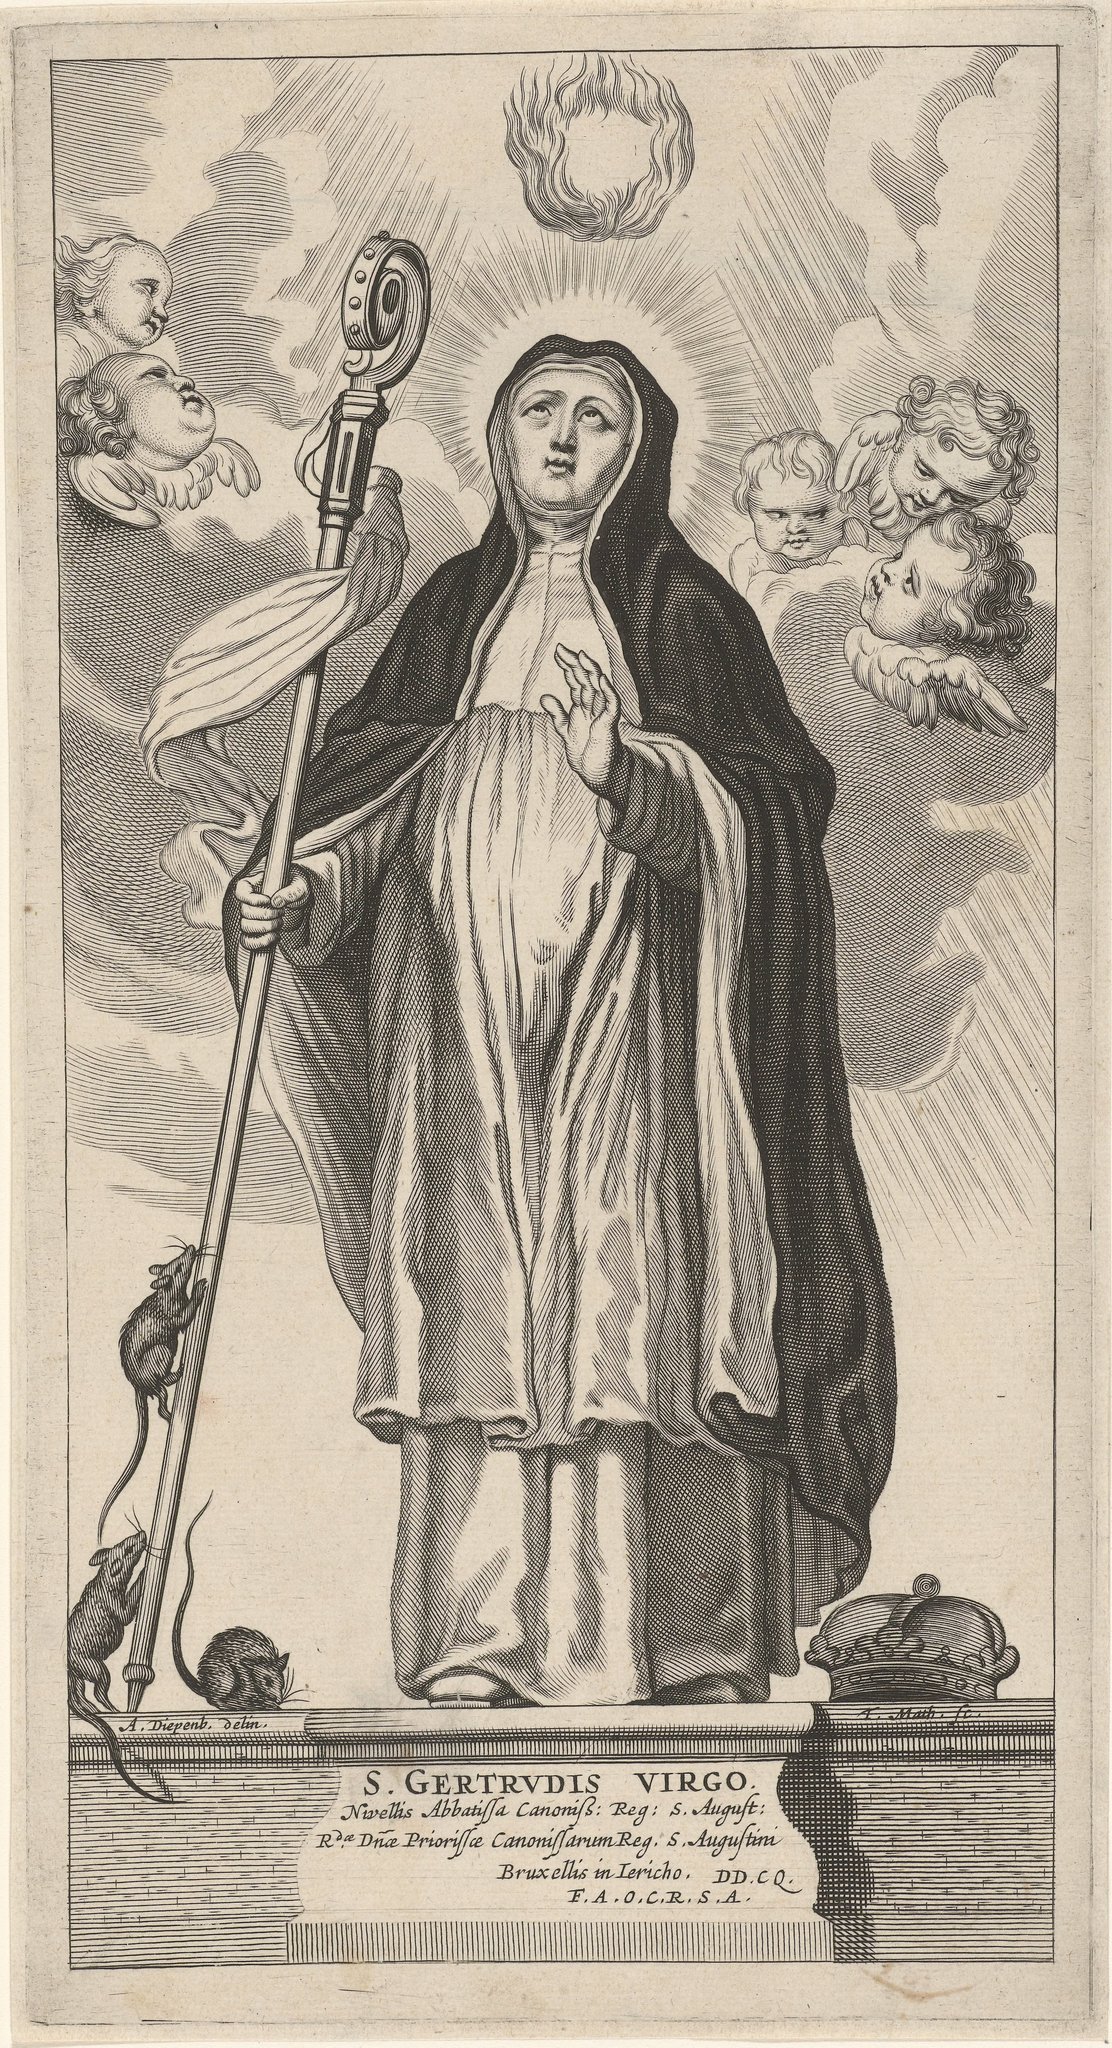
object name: print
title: Heiligen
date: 1615-1676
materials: paper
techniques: engraving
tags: cherubs, i.e. children's heads with wings, saints, the abbess gertrude of nivelles; possible attributes: book, pastoral staff, crown, cup, demon, mouse or mice, model of church or hospital, palm, (healing) well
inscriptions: collector's mark: Lugt 240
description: De heilige Gertrudis van Nijvel, met in haar hand een staf waartegen muizen kruipen. Aan haar voeten een kroon. In de lucht cherubijnen. Prent uit een serie van acht prenten met heiligen.